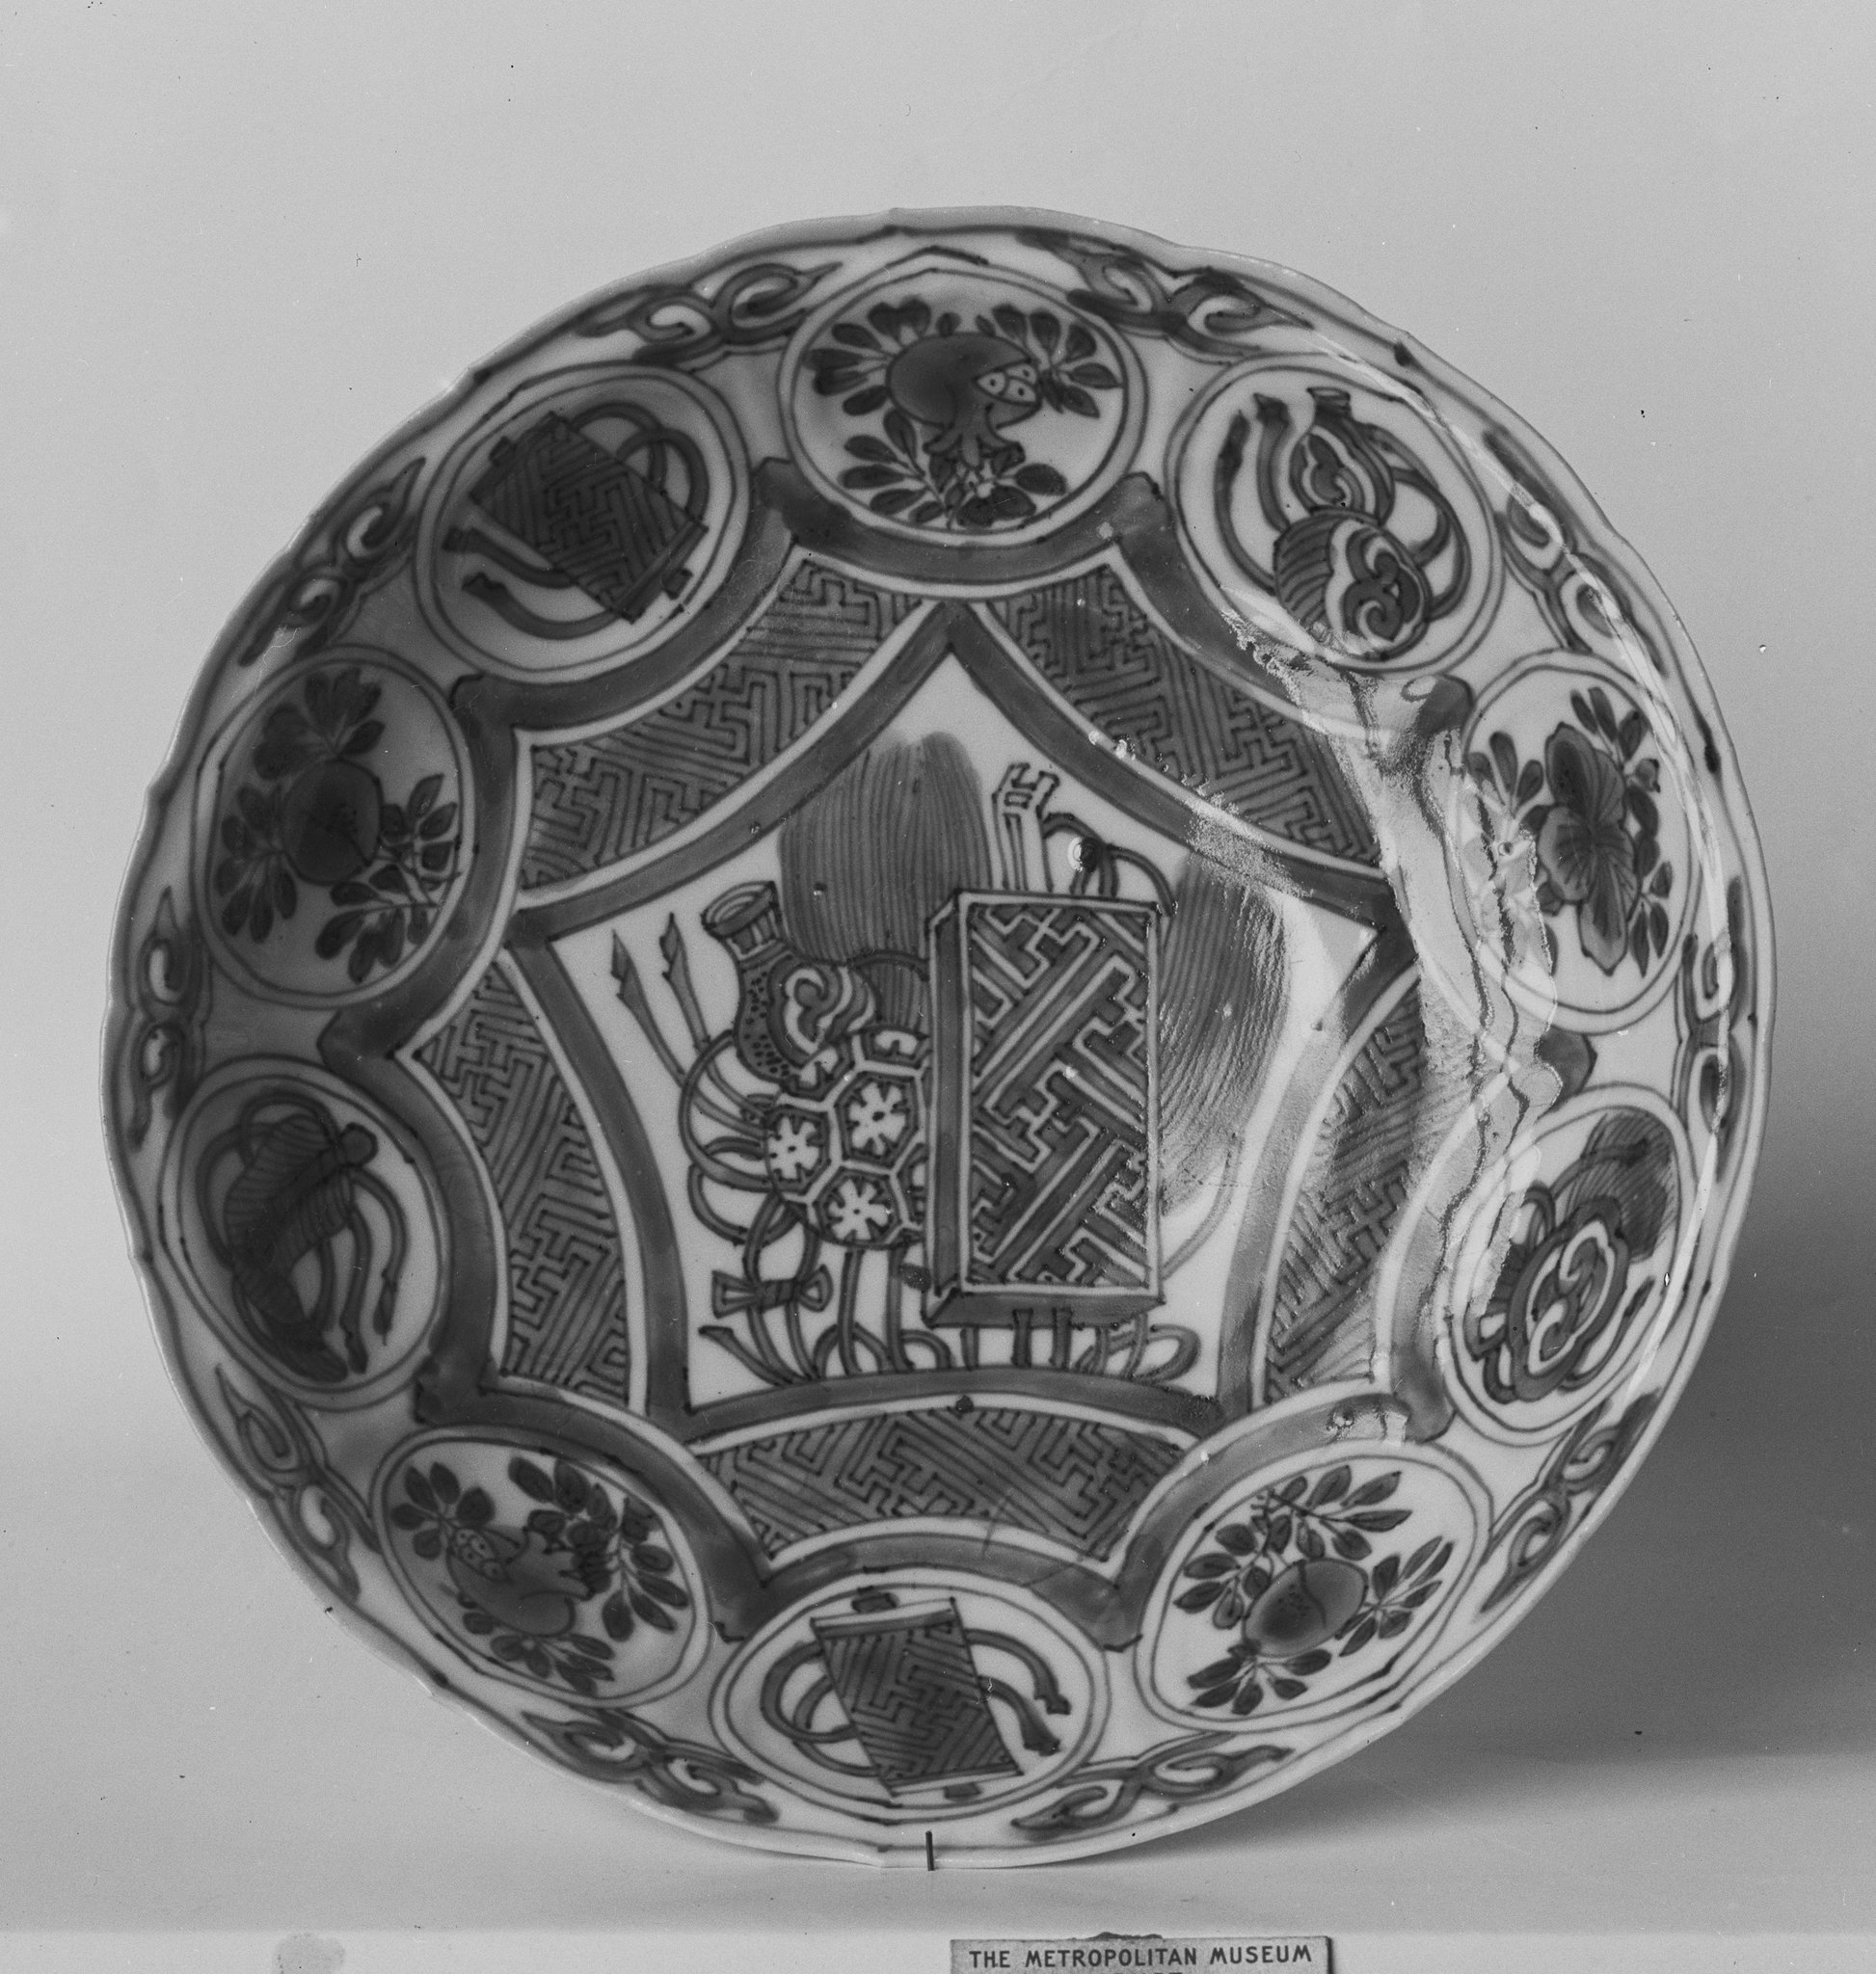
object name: dish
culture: chinese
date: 1600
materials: porcelain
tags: flowers,leaves